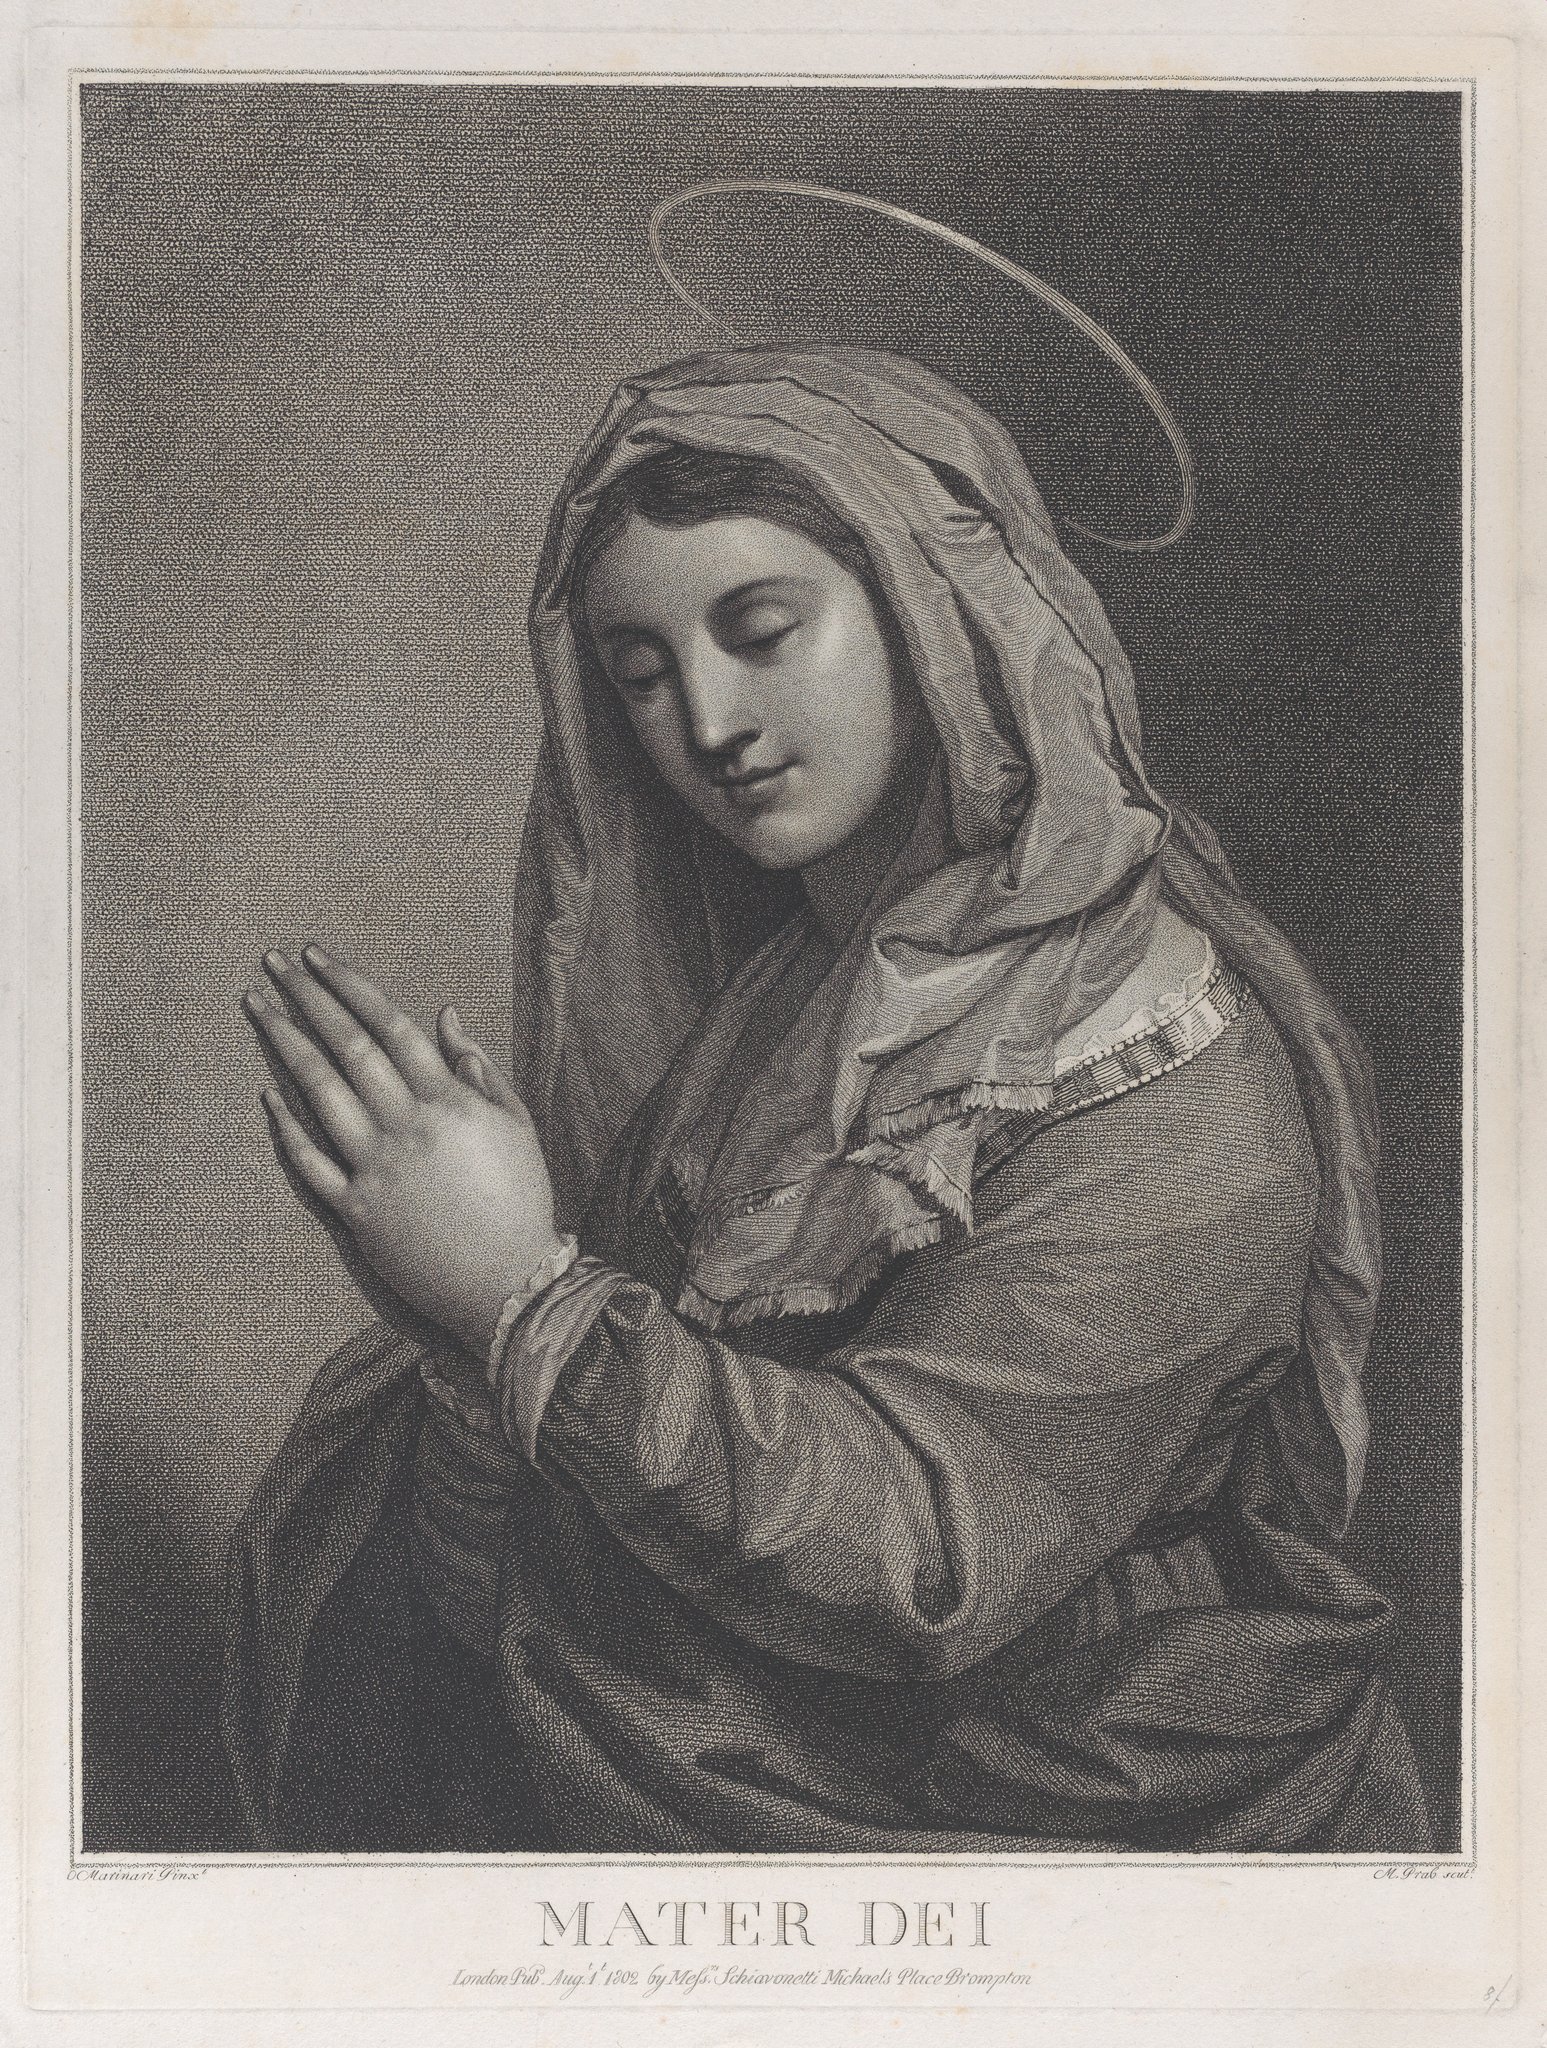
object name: print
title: Mater Dei, the Virgin in prayer towards the left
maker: Anonymous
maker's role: artist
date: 1802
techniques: engraving